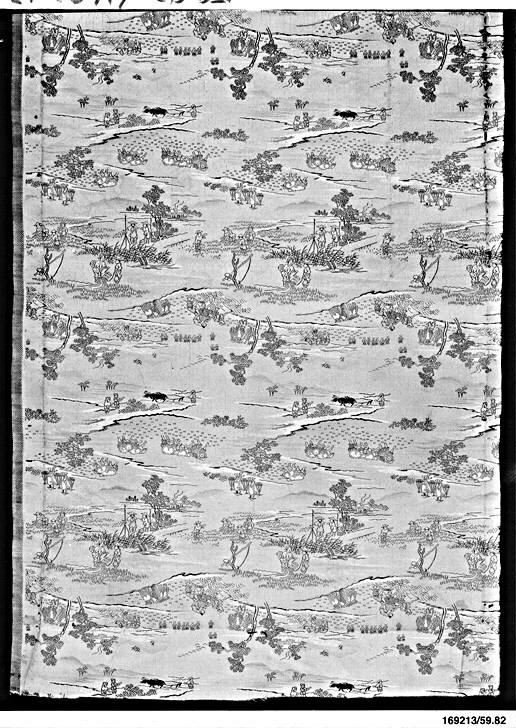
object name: piece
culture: japanese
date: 1867-1933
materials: silk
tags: human figures,animals,landscapes,trees